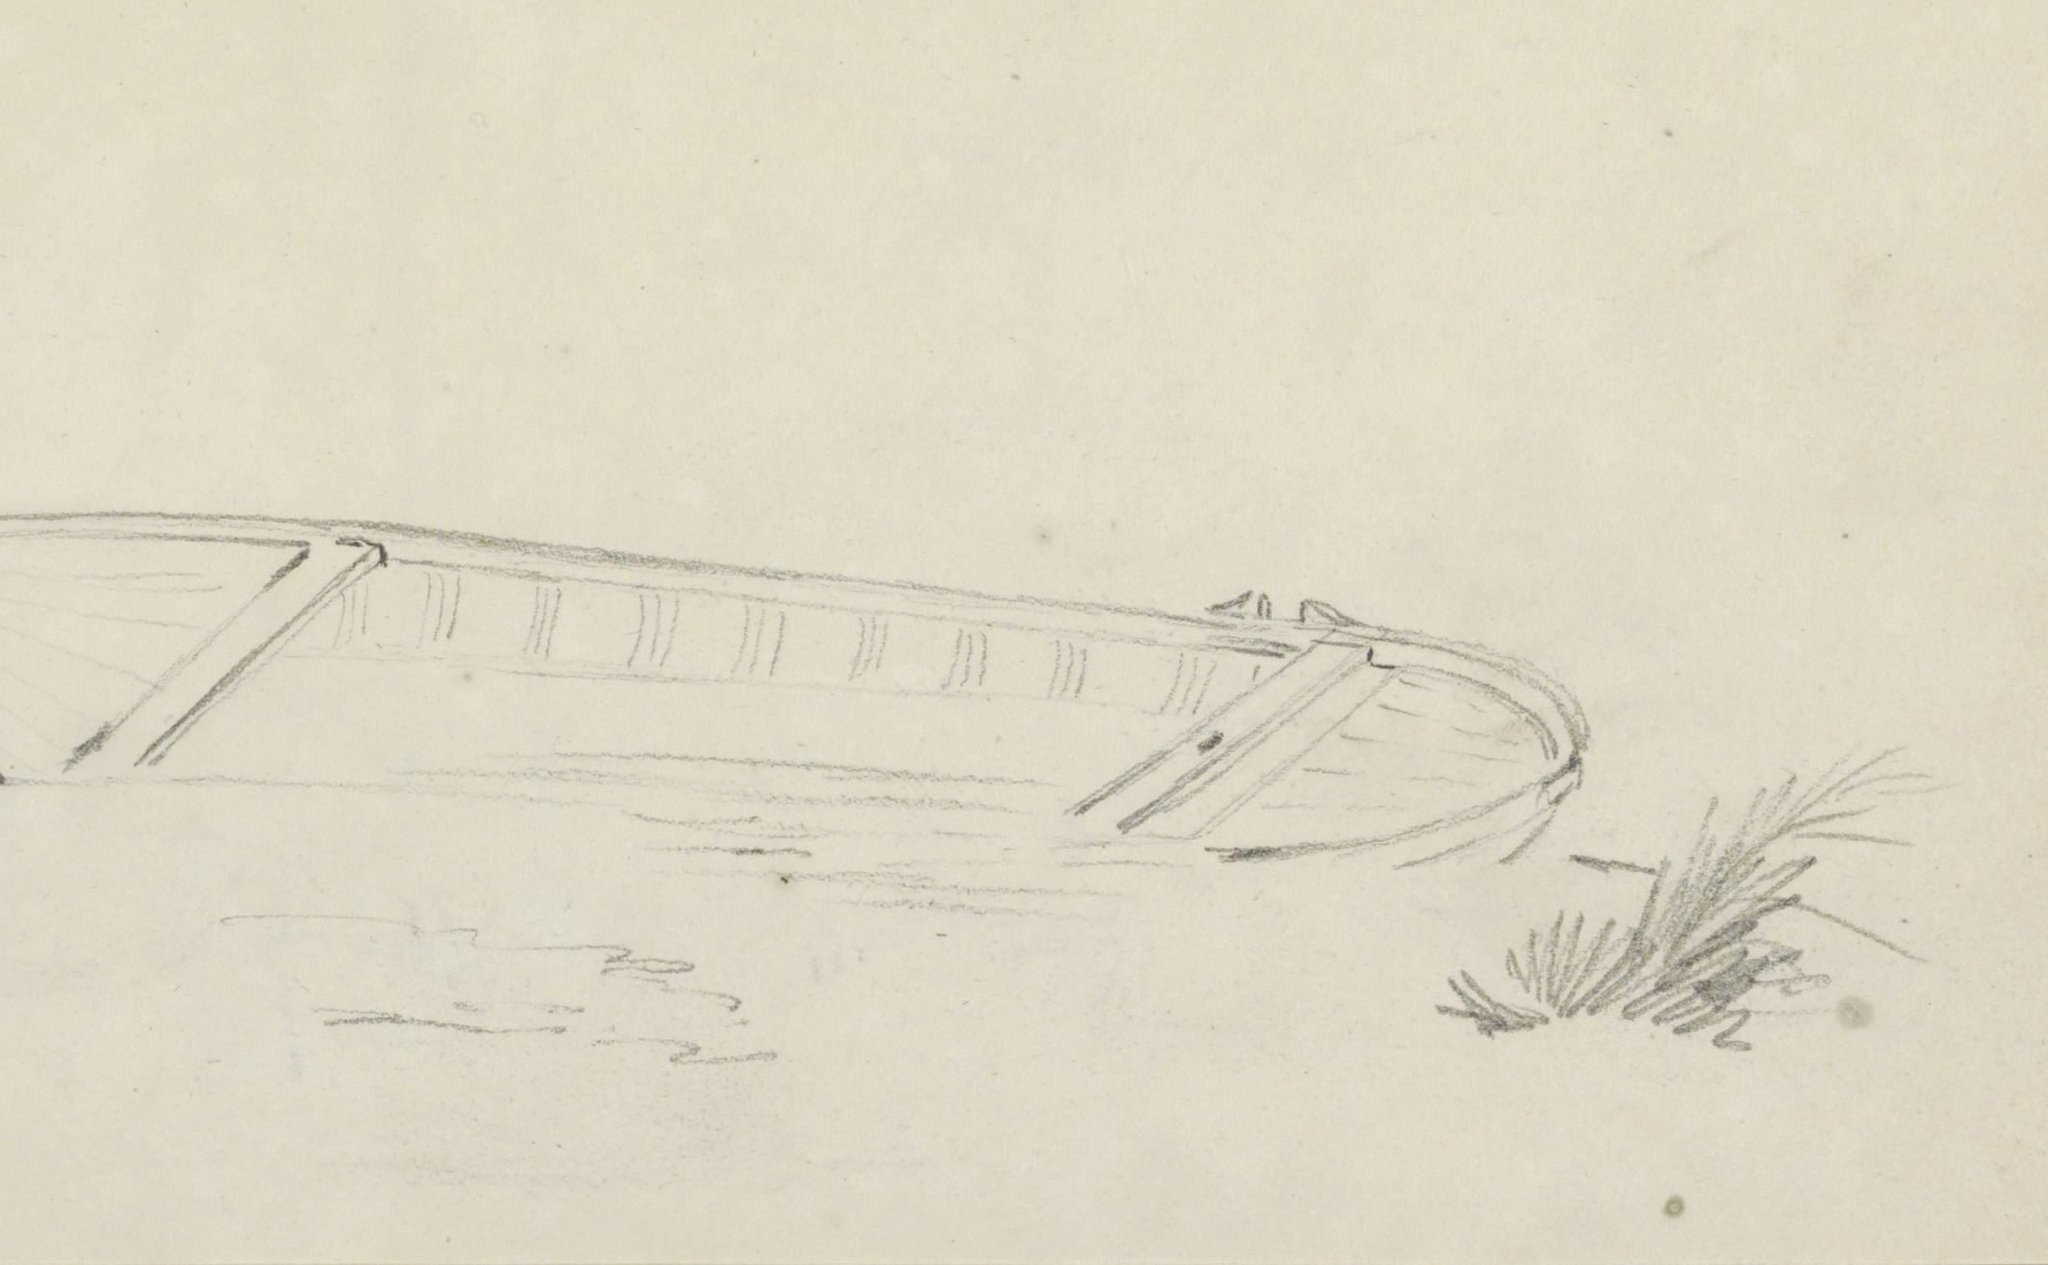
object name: sketchbook leaf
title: Roeiboot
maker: adrianus eversen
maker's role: draughtsman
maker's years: 1818-1897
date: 1828-1897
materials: paper, pencil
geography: netherlands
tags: rowing-boat, canoe, etc.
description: Aan wal ligt een gekantelde roeiboot. Blad 11 recto uit een schetsboek met 27 bladen.